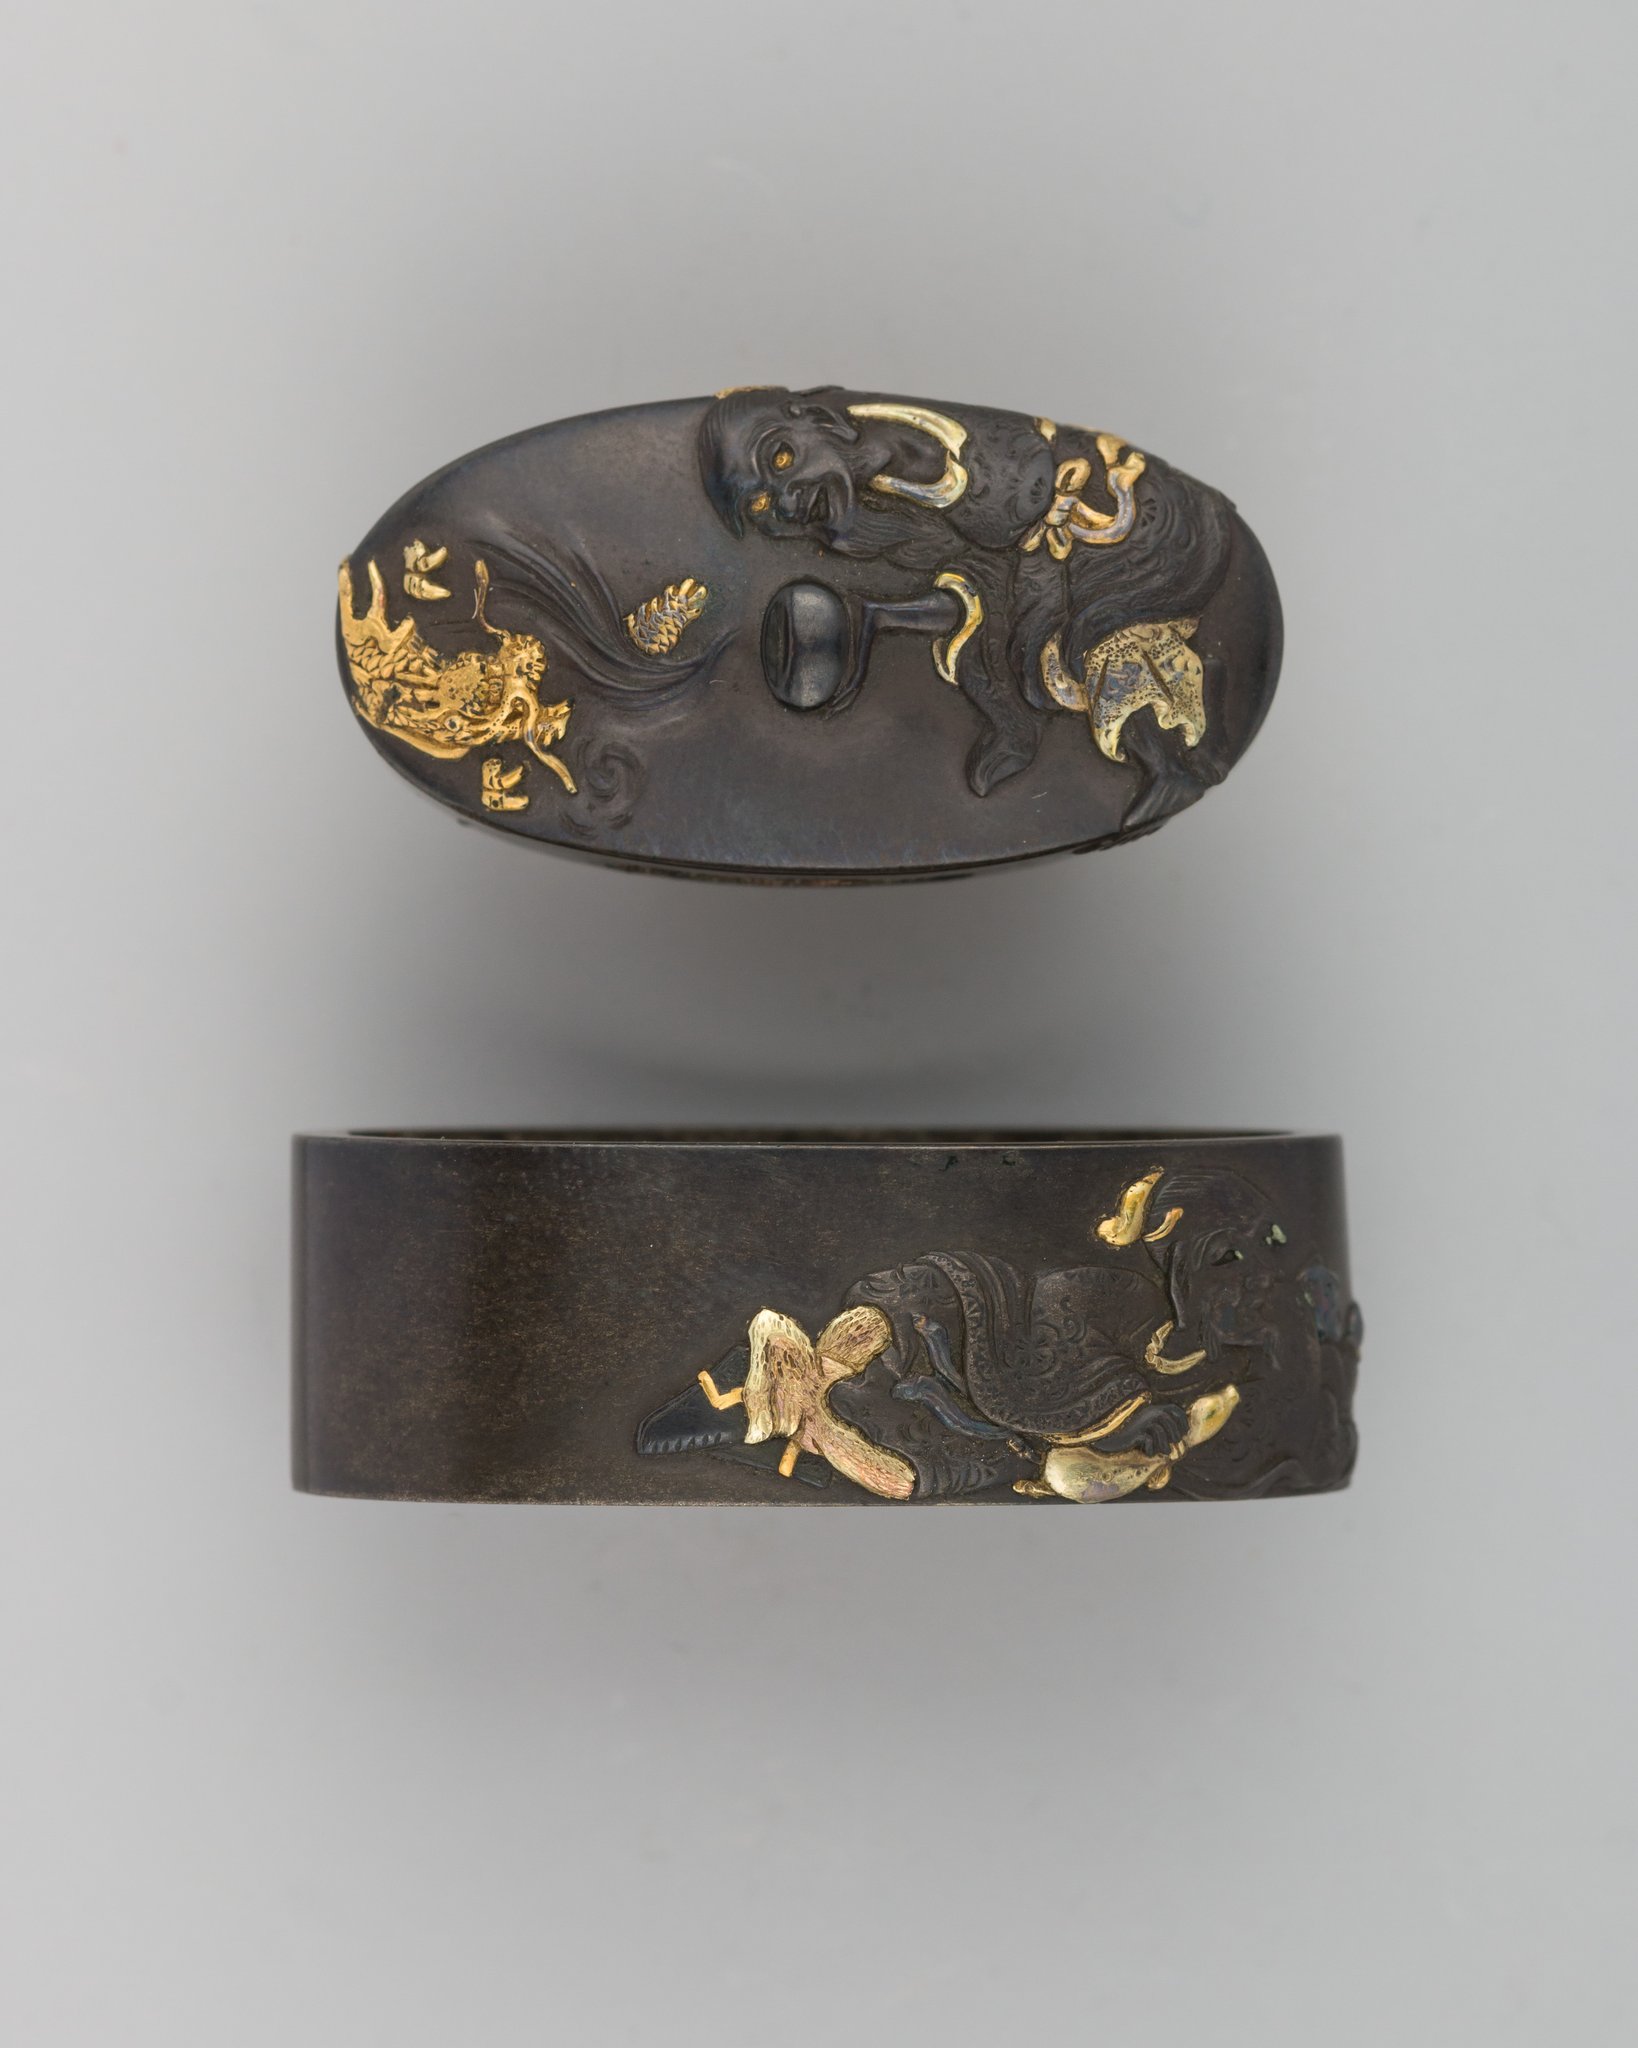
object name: sword hilt collar and pommel fuchigashira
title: Sword-Hilt Collar and Pommel (Fuchigashira)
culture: japanese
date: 1834-1866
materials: gold alloy, silver alloy, gold, silver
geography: japan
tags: men